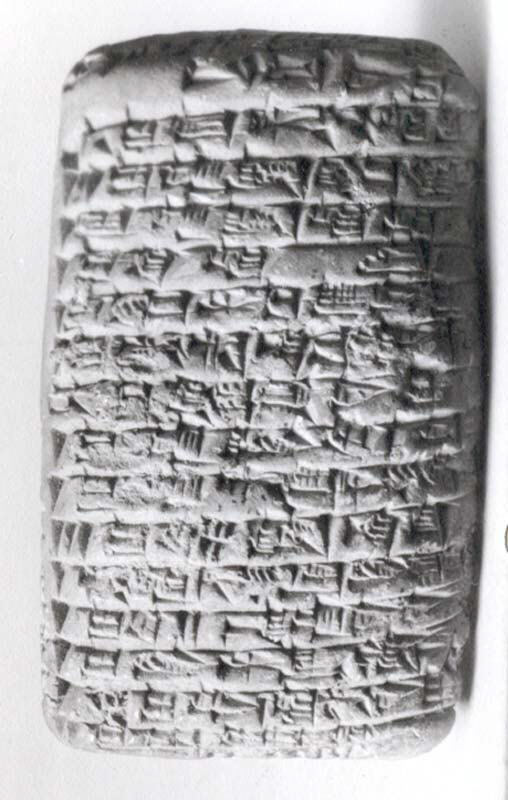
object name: cuneiform tablet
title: Cuneiform tablet: balanced account of Shu-ili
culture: neo-sumerian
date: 2040 BCE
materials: clay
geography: mesopotamia